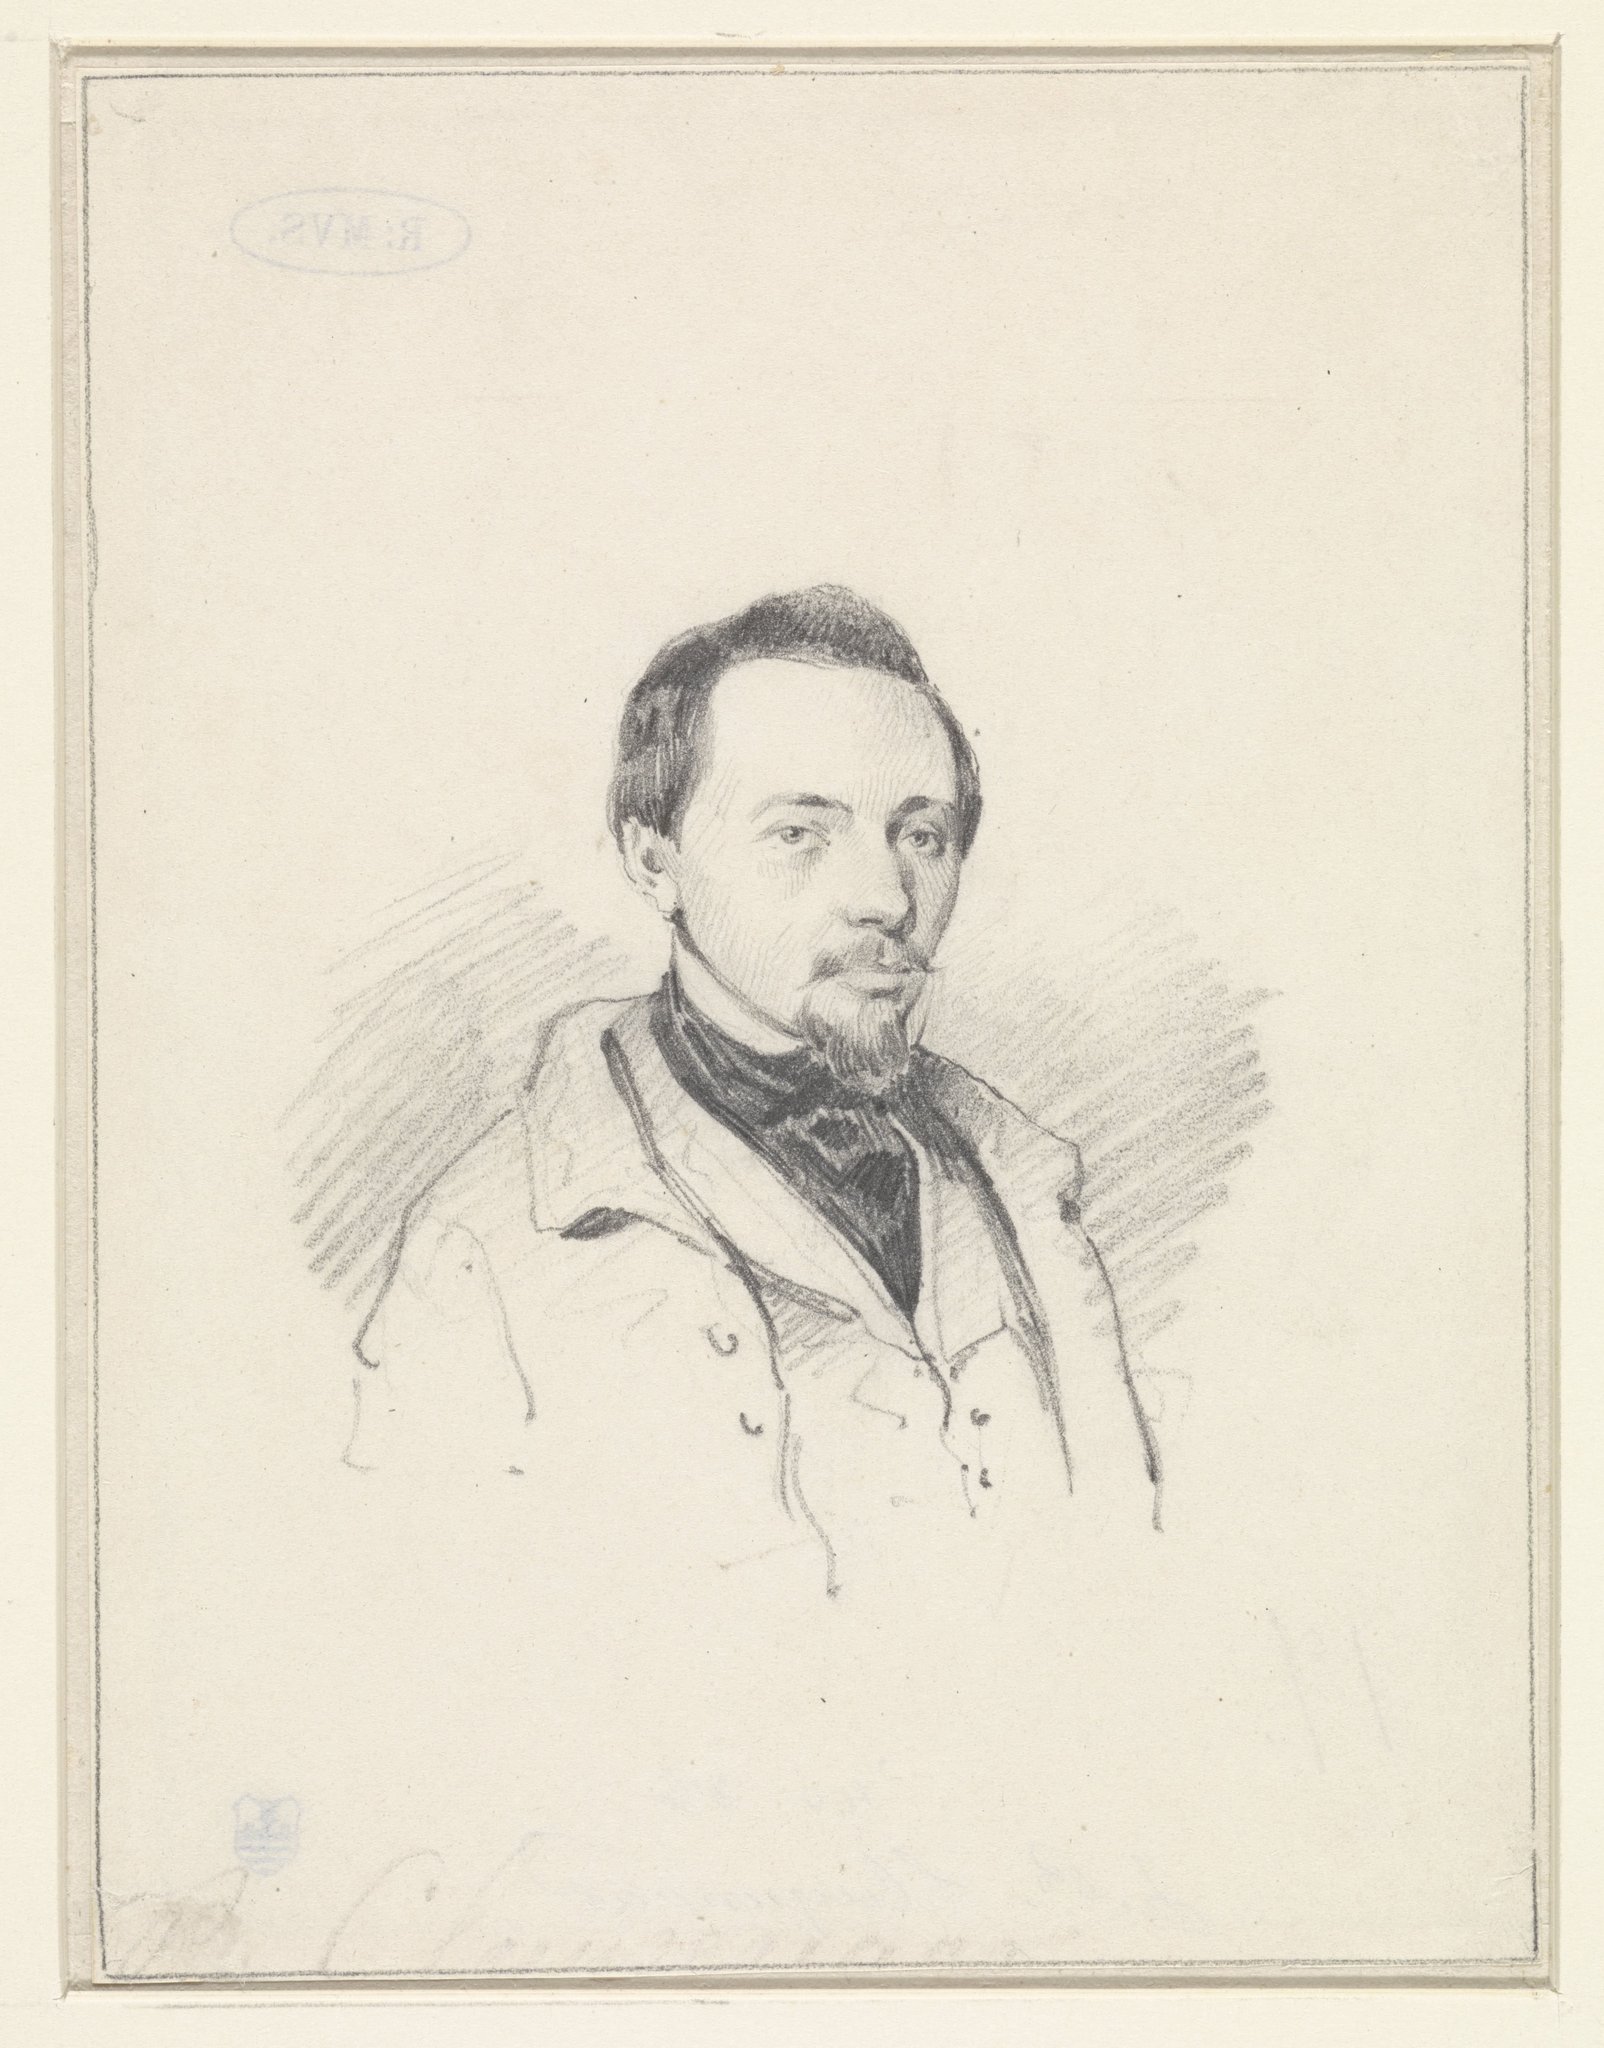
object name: drawing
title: Portret van Jean Pierre Cluysenaar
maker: jean pierre cluysenaar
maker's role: draughtsman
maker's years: 1811-1880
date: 1841-1842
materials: paper, pencil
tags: brussels, jean pierre cluysenaar, historical persons, portrait, self-portrait of painter, portrait, self-portrait of artist, portrait, self-portrait of draughtsman